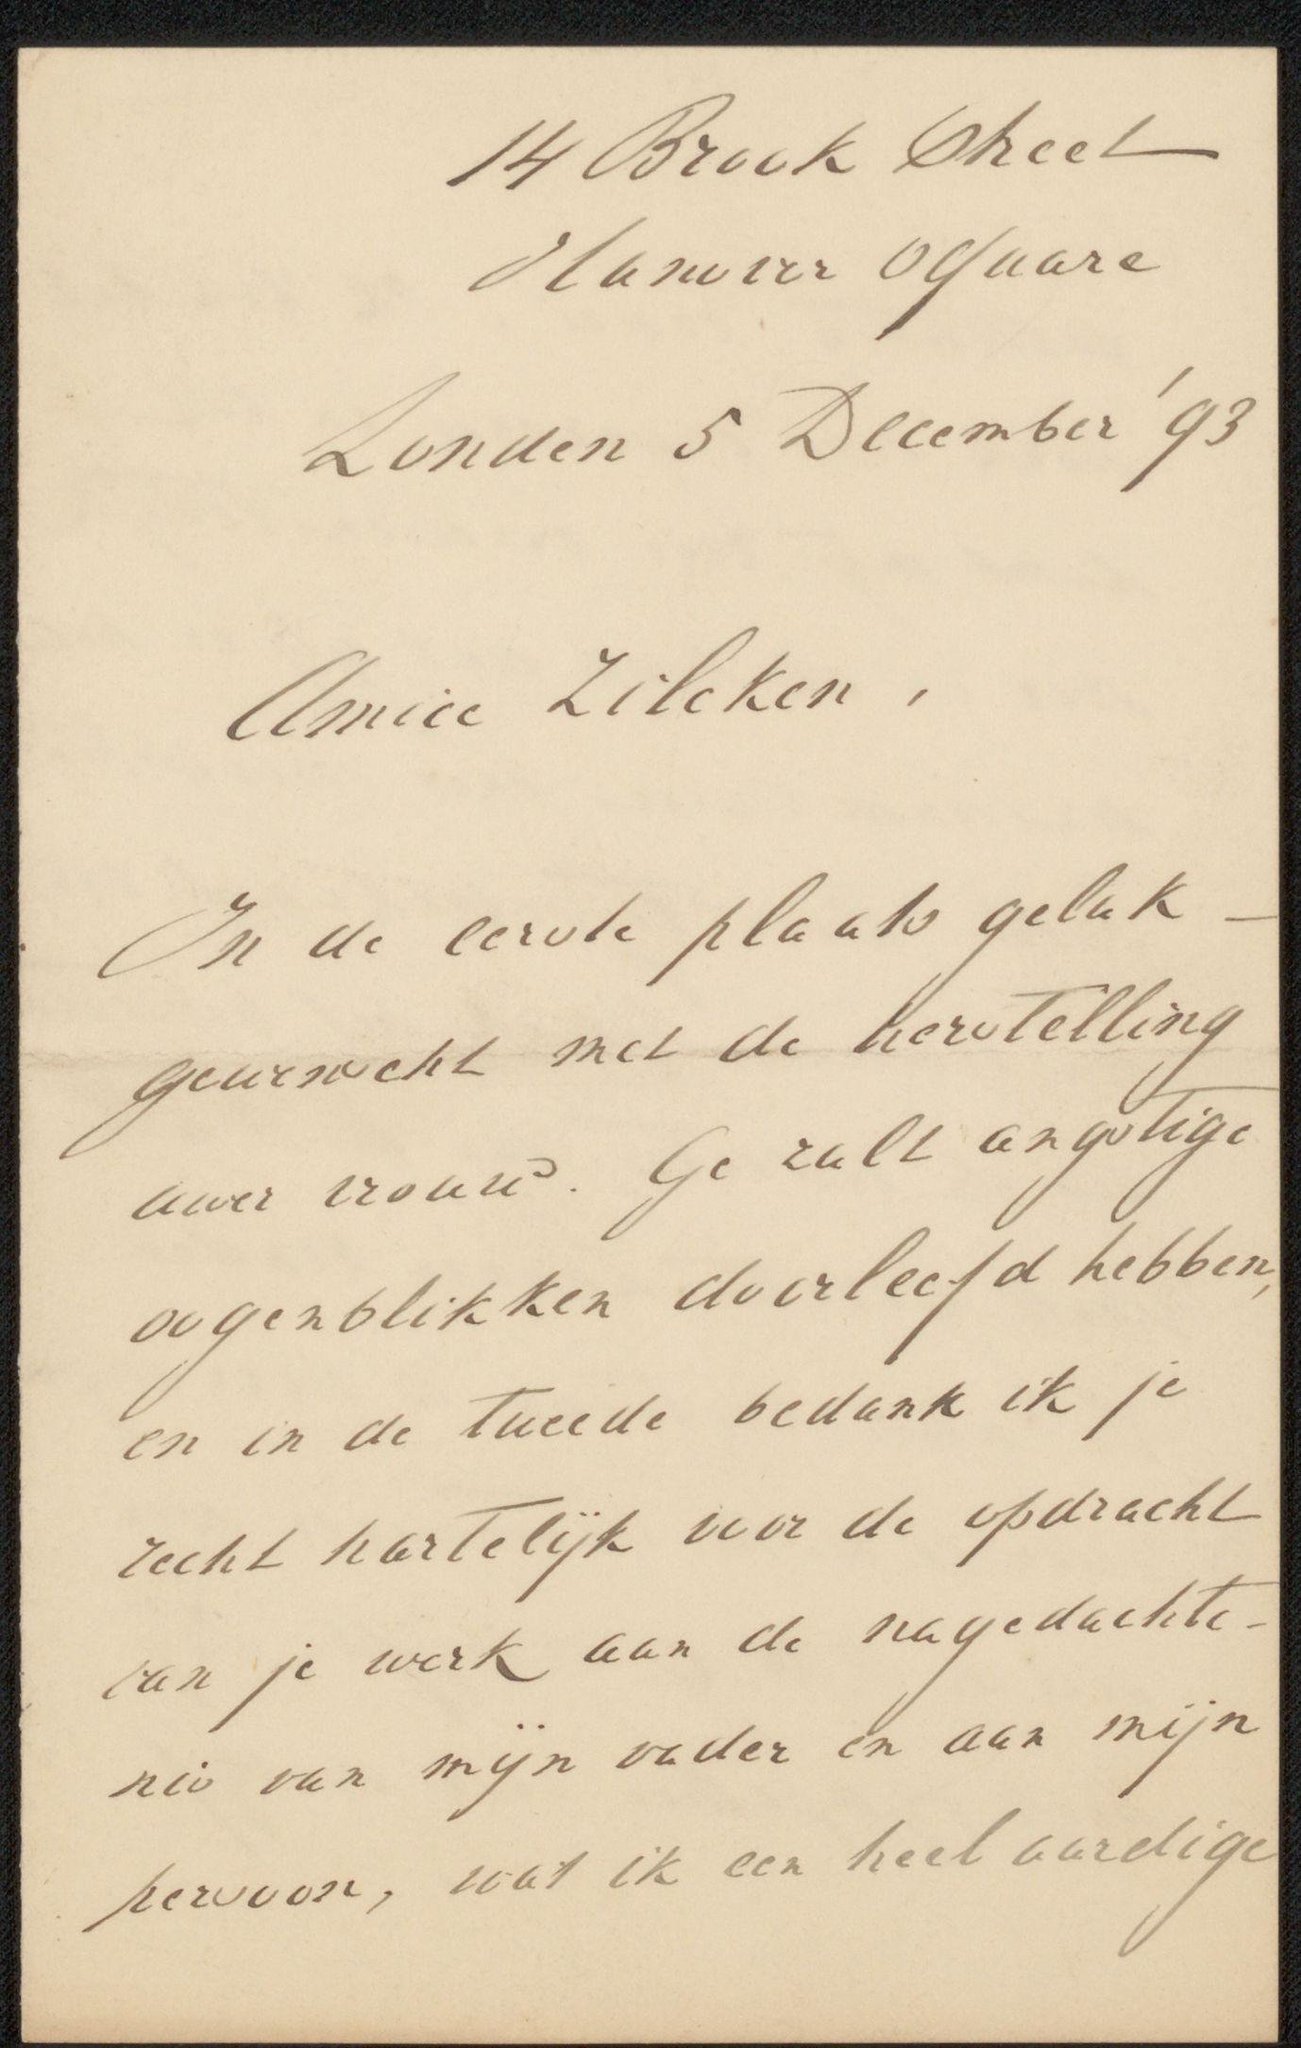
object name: letter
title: Brief aan Philip Zilcken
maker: elbert jan van wisselingh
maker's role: kunsthandelaar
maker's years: 1848-1912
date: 1893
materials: ink, paper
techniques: pen, writing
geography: london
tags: london, matthijs maris, willem maris, print maker, jacob maris, printer, publisher, paul verlaine, amsterdam, draughtsman, hermanus gijsbertus tersteeg, helène lambertine hauzeur, the hague, painter, philip zilcken, printed matter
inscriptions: collector's mark: ‘RPK’, watermark